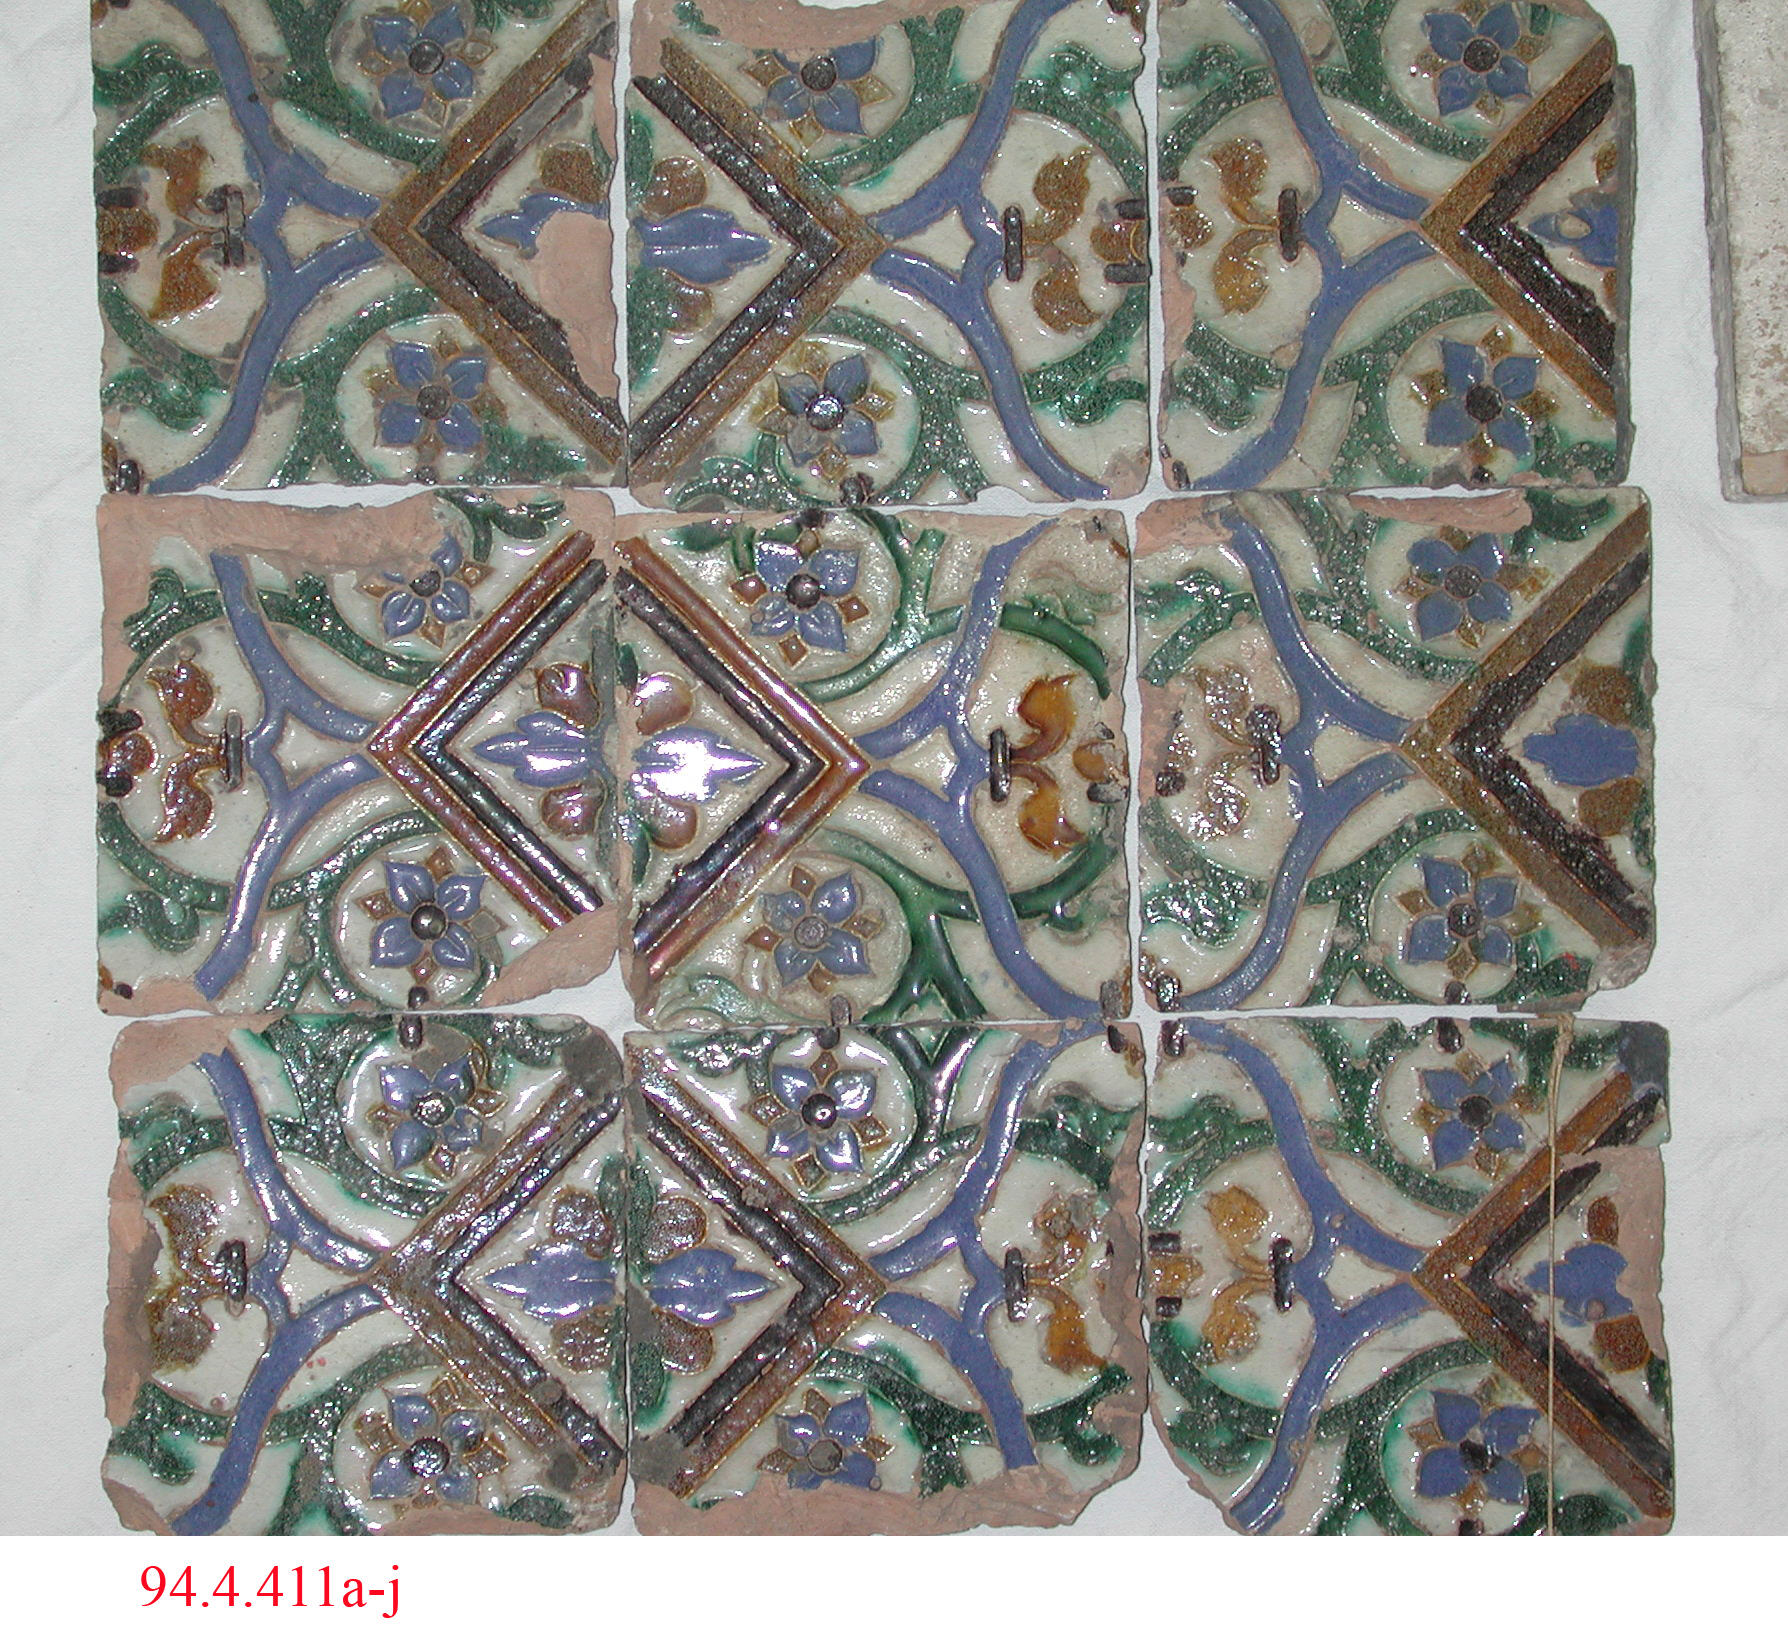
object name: tile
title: Tiles (10)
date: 1501-1700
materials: earthenware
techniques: glazing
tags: flowers